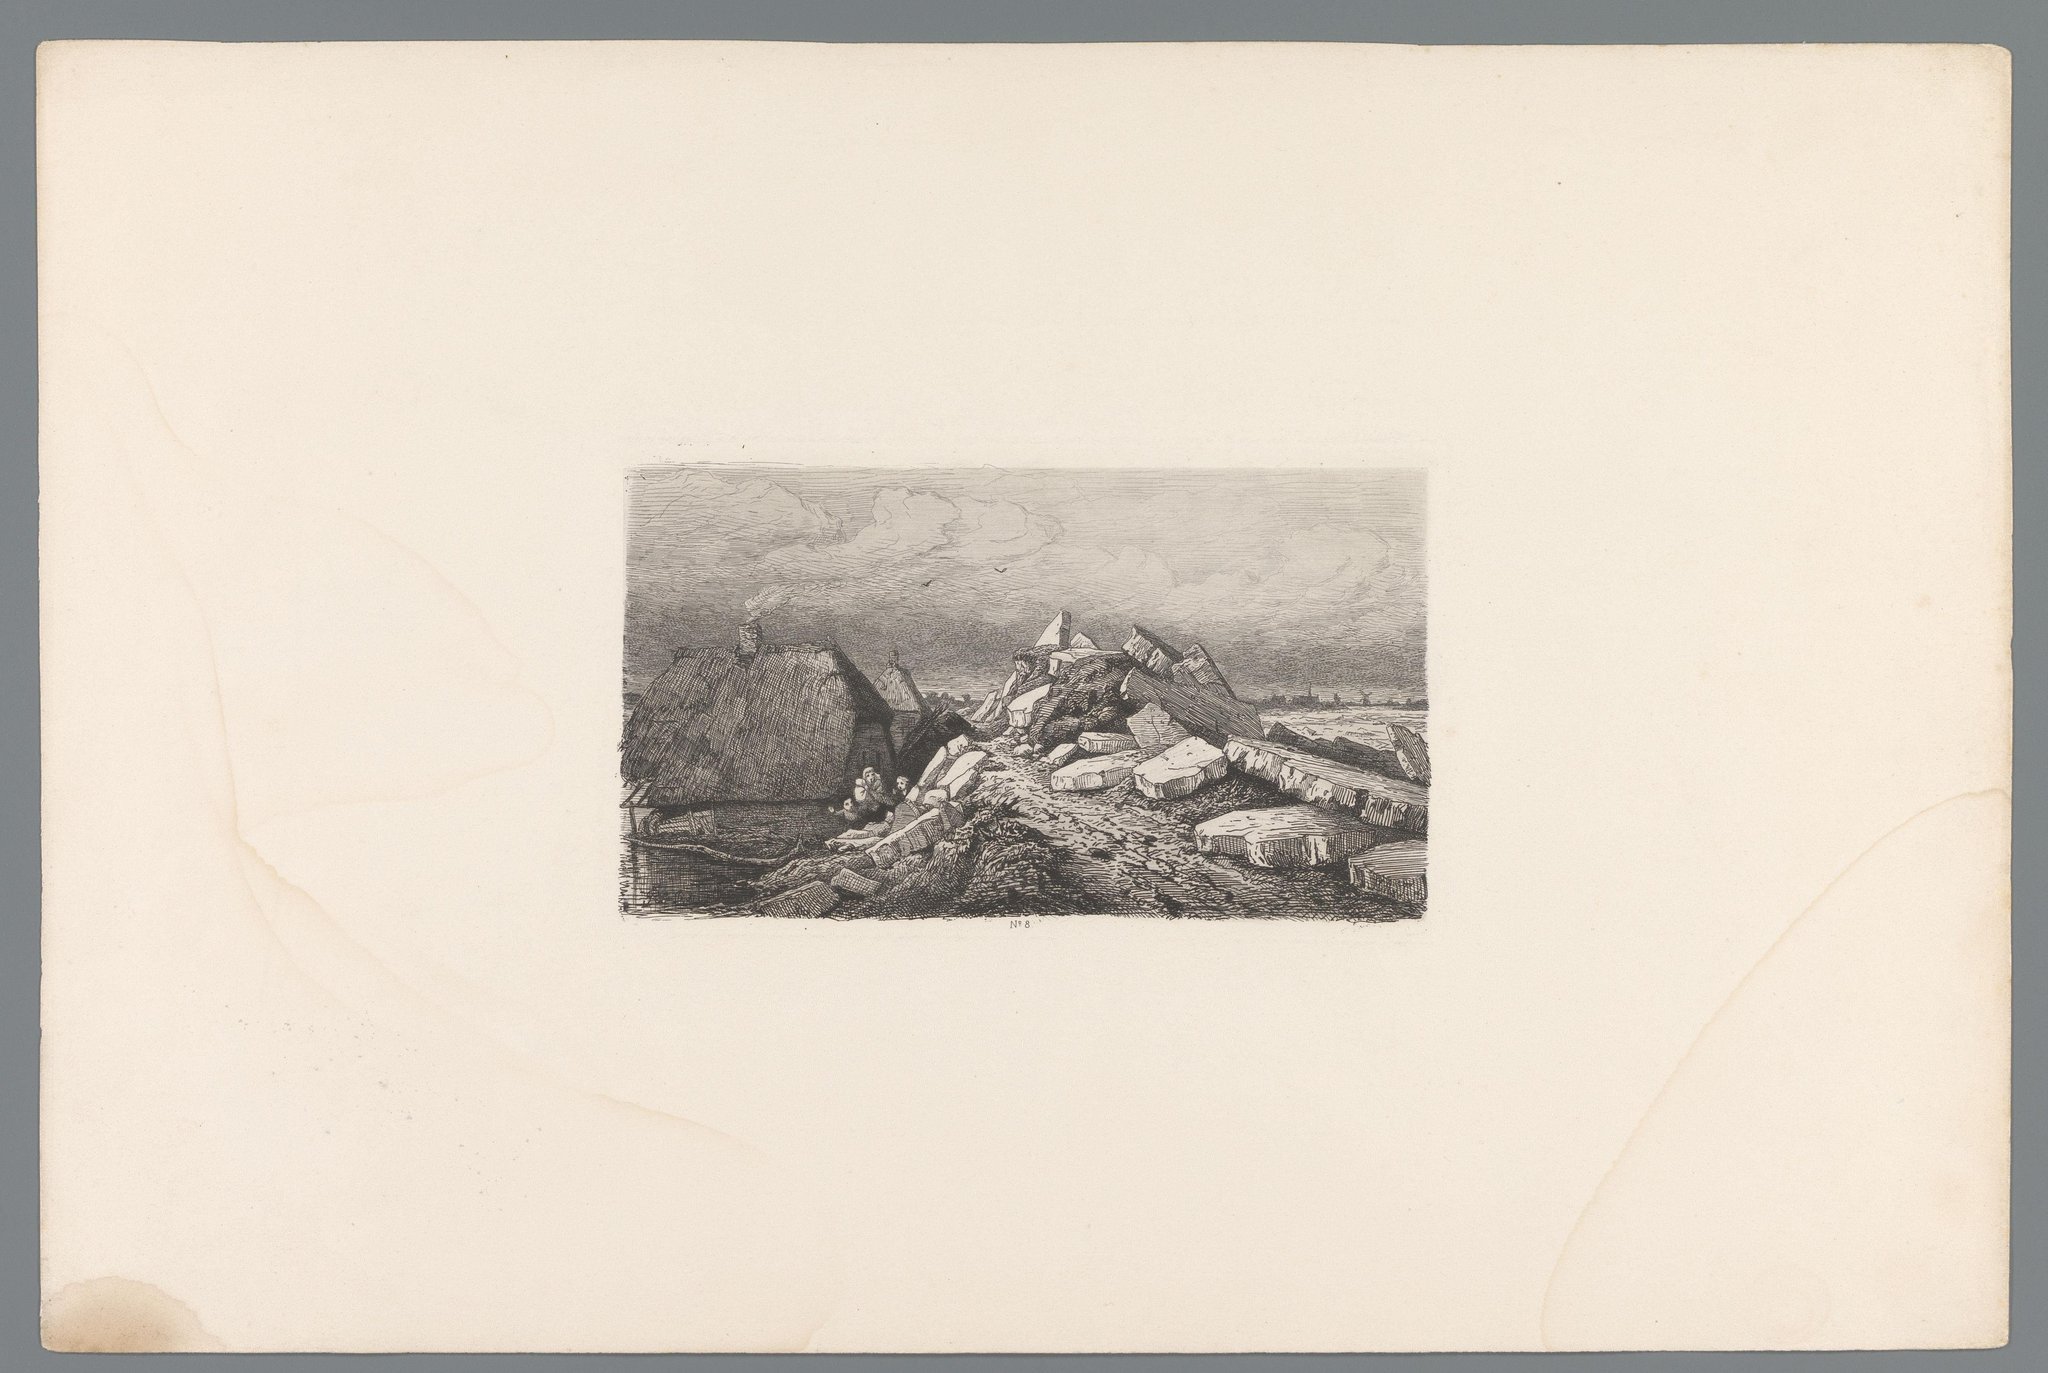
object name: print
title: Watersnood van 1855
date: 1855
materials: paper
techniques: etching, intaglio, roulette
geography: netherlands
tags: flood, drift ice